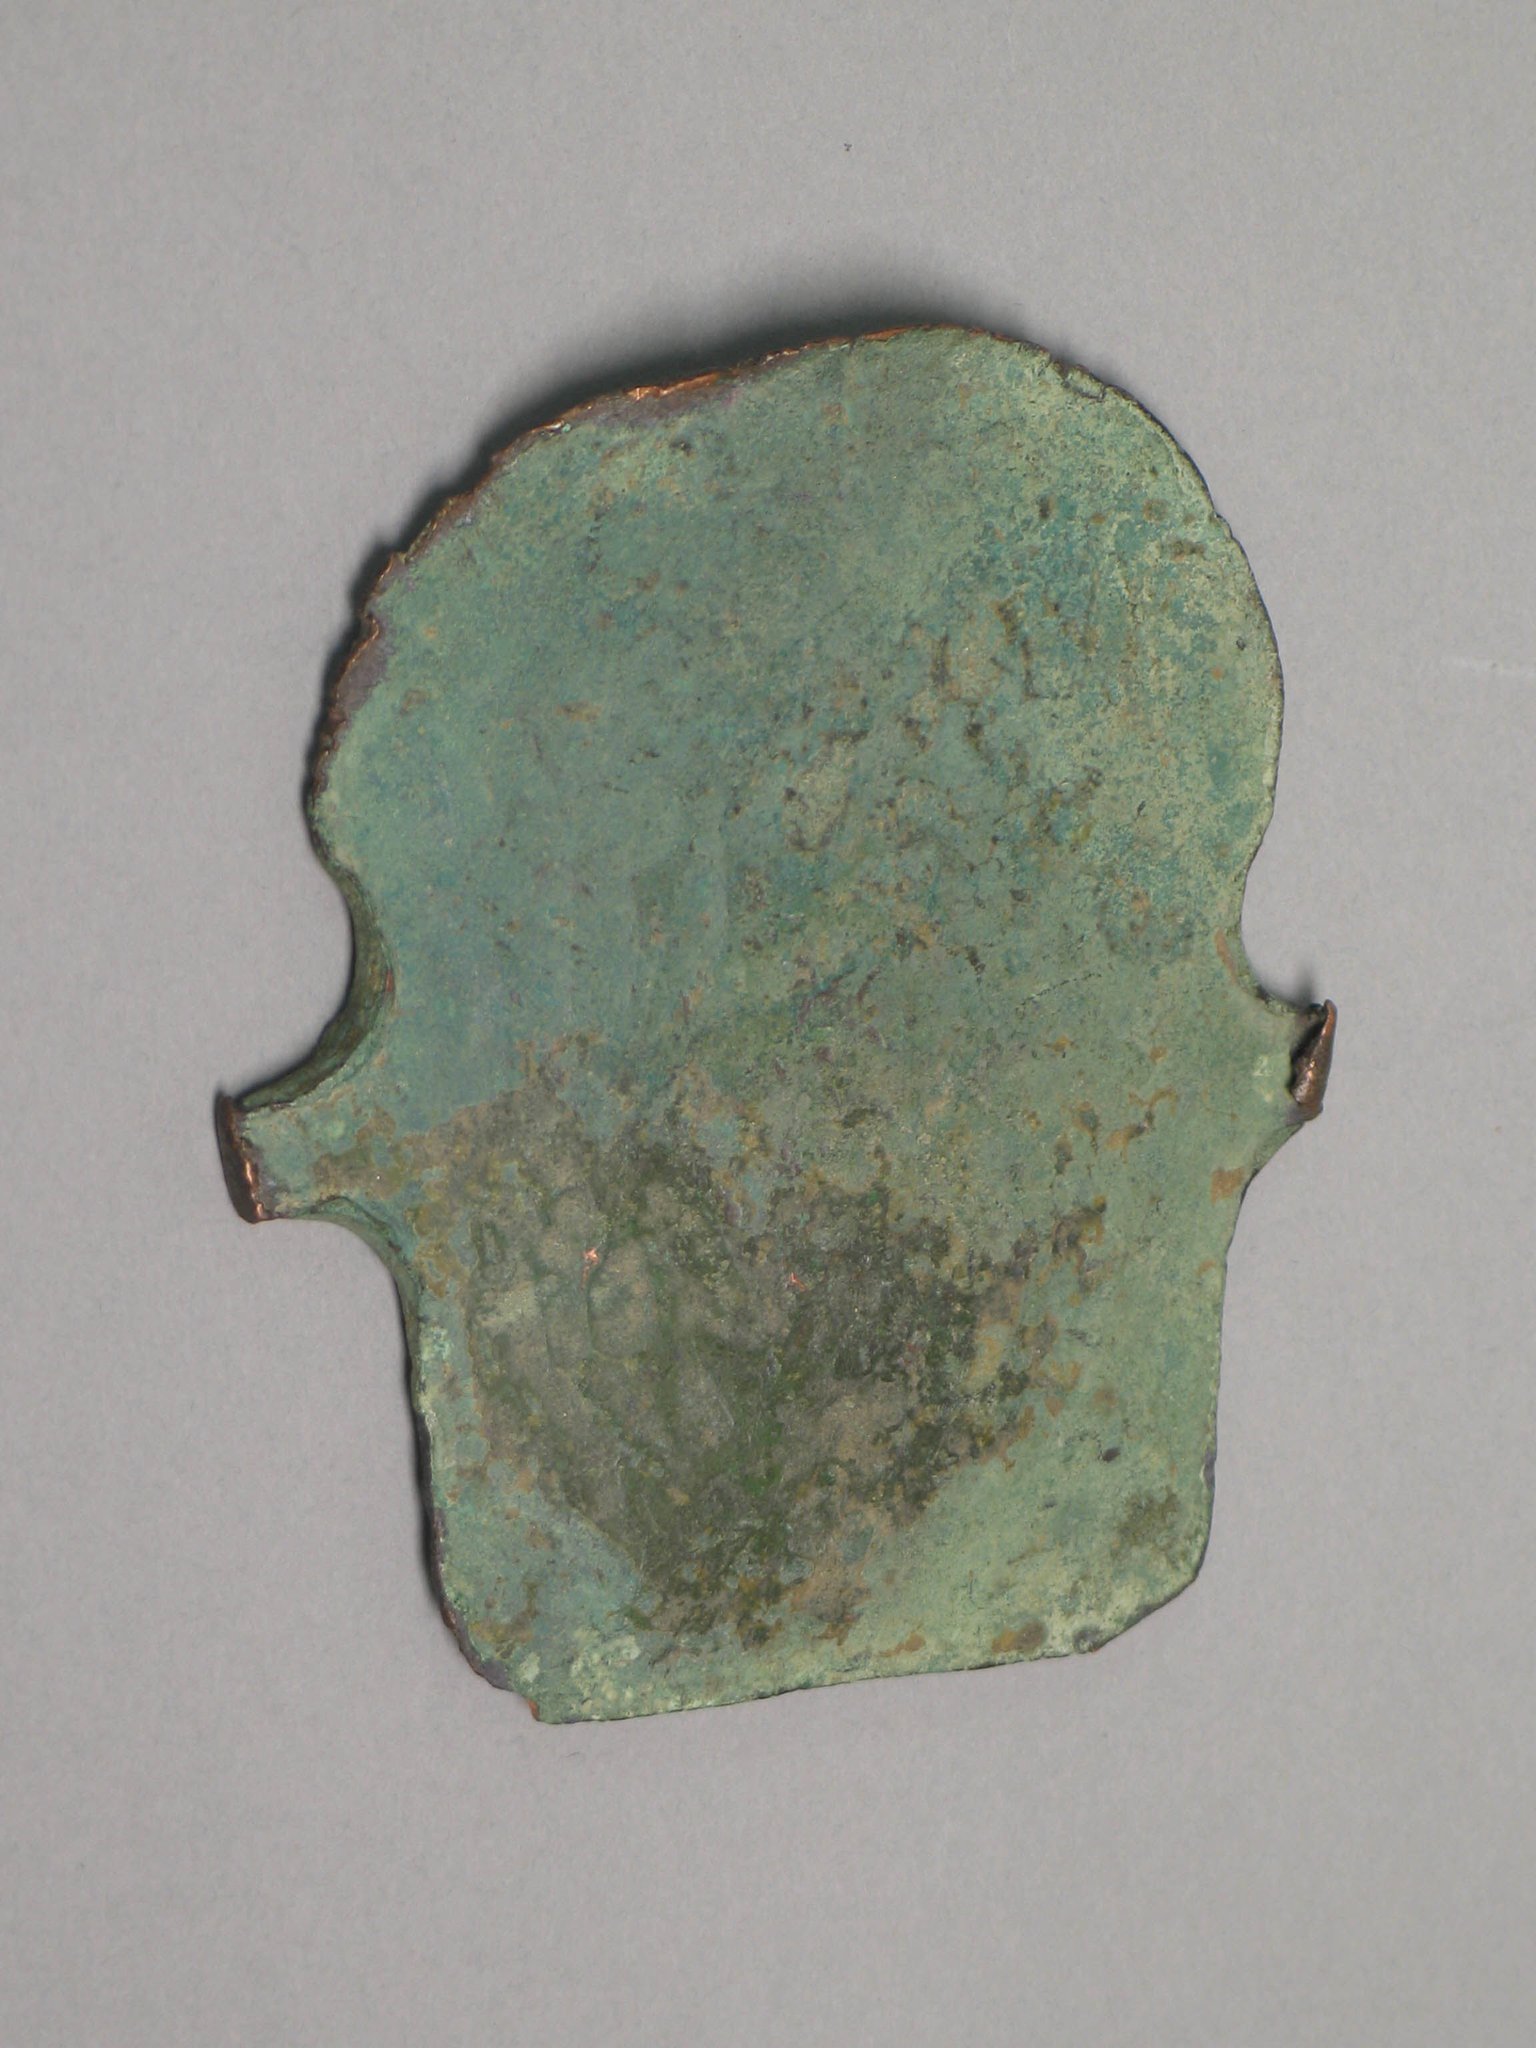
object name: ax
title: Ax in Anthropomorphic Shape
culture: indian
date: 1500-500 BCE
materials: copper